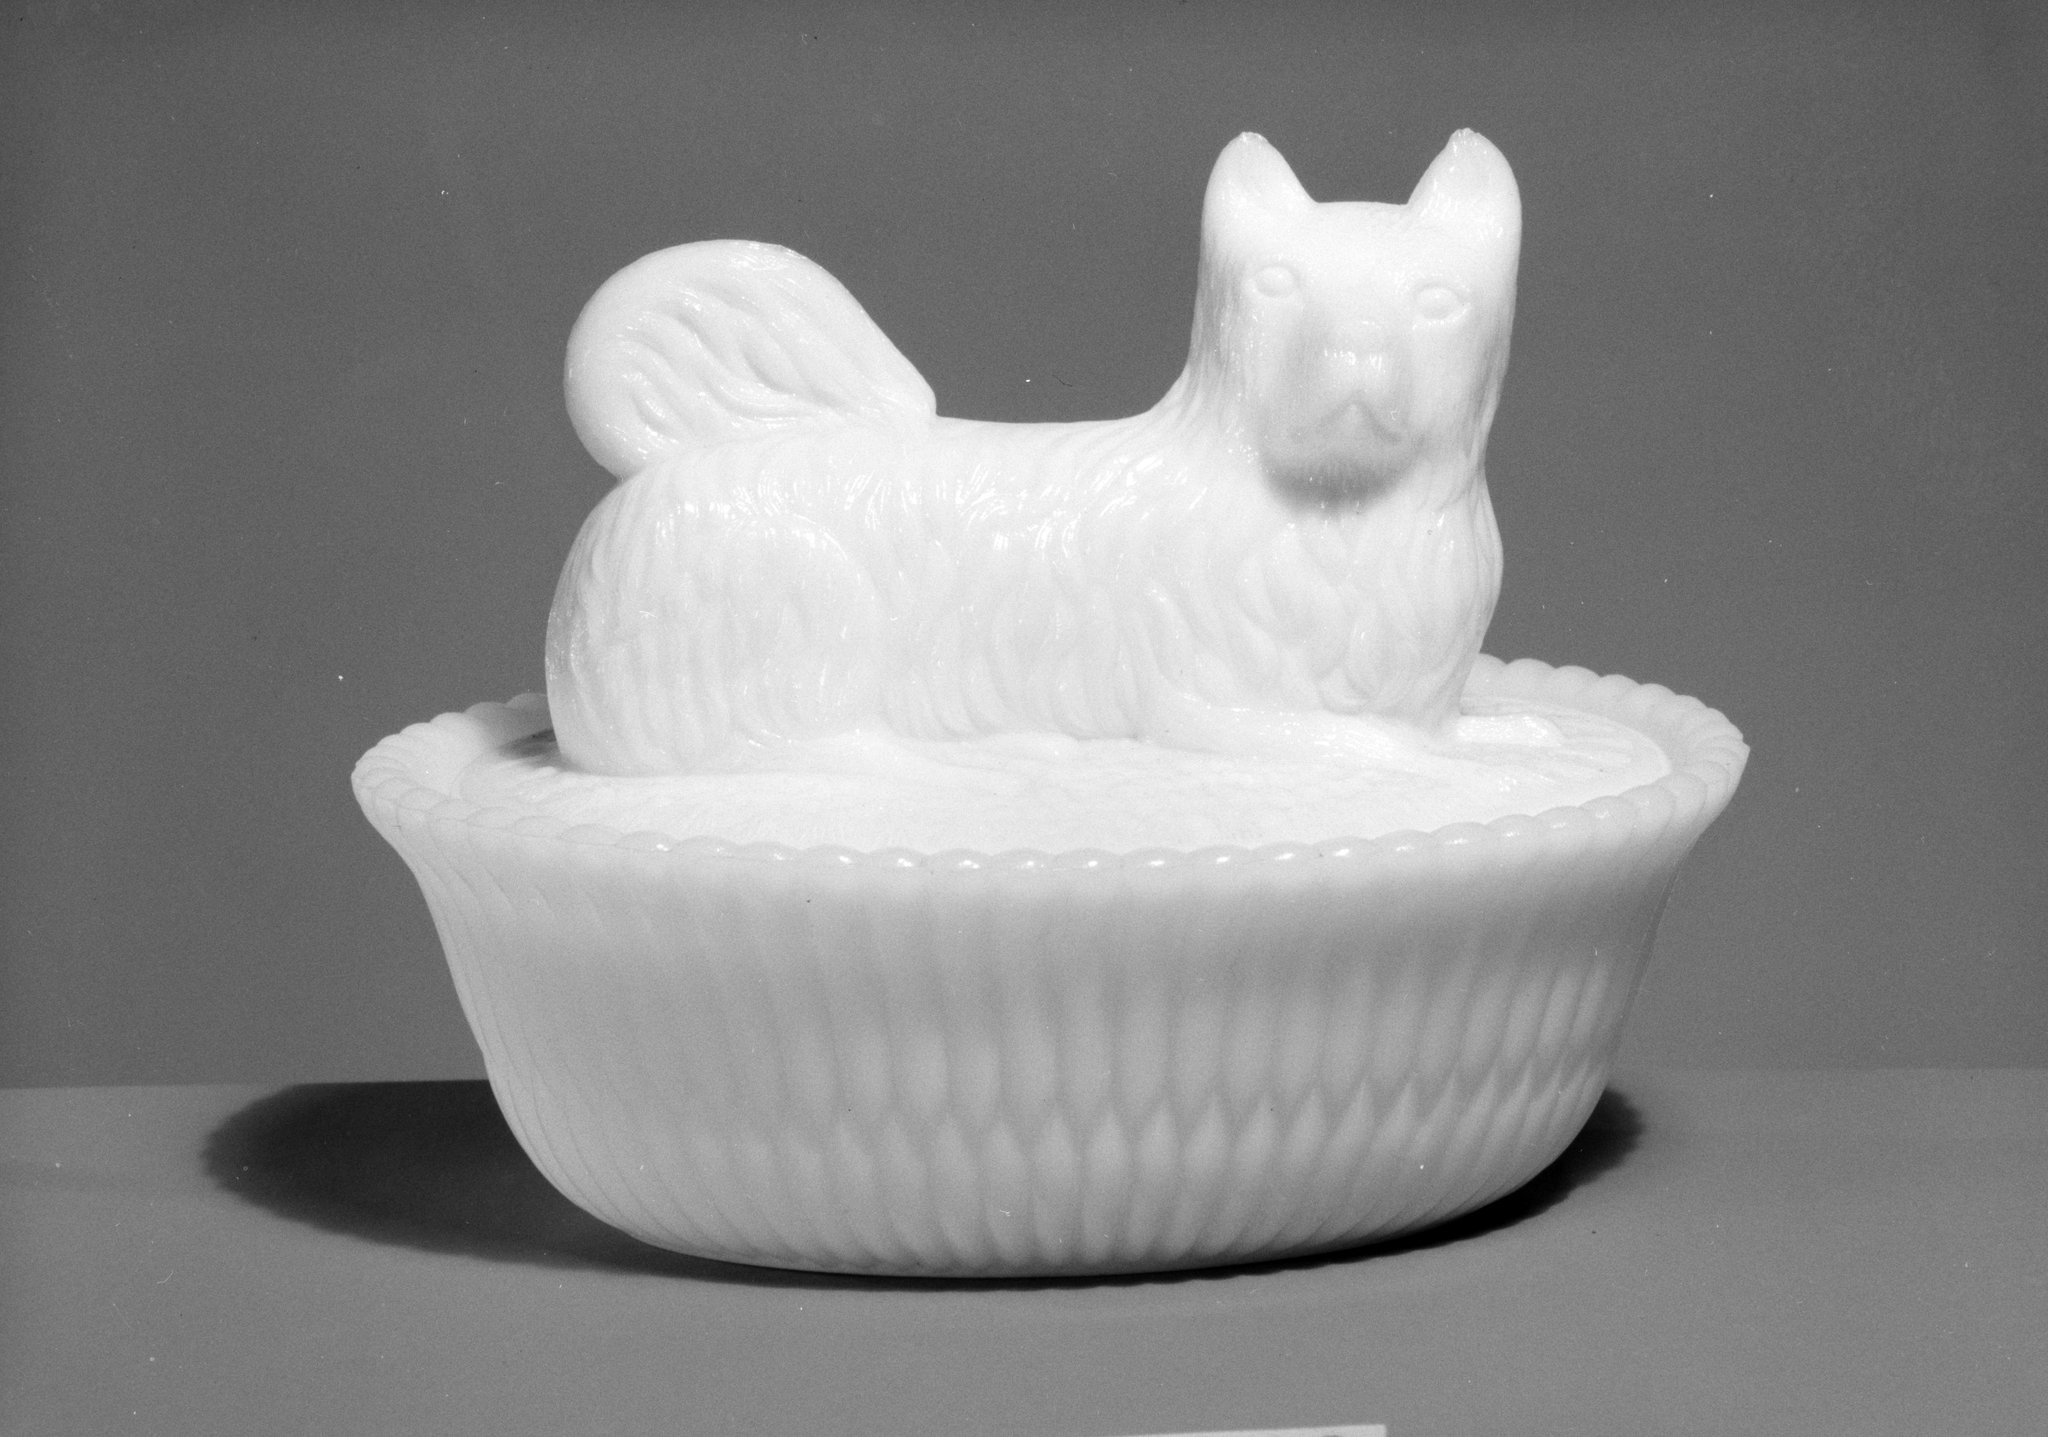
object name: dish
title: Figure Dish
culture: american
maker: mckee and brothers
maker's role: maker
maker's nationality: american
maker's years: 1856-1889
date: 1880-1890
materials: glass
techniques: pressed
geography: united states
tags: animals